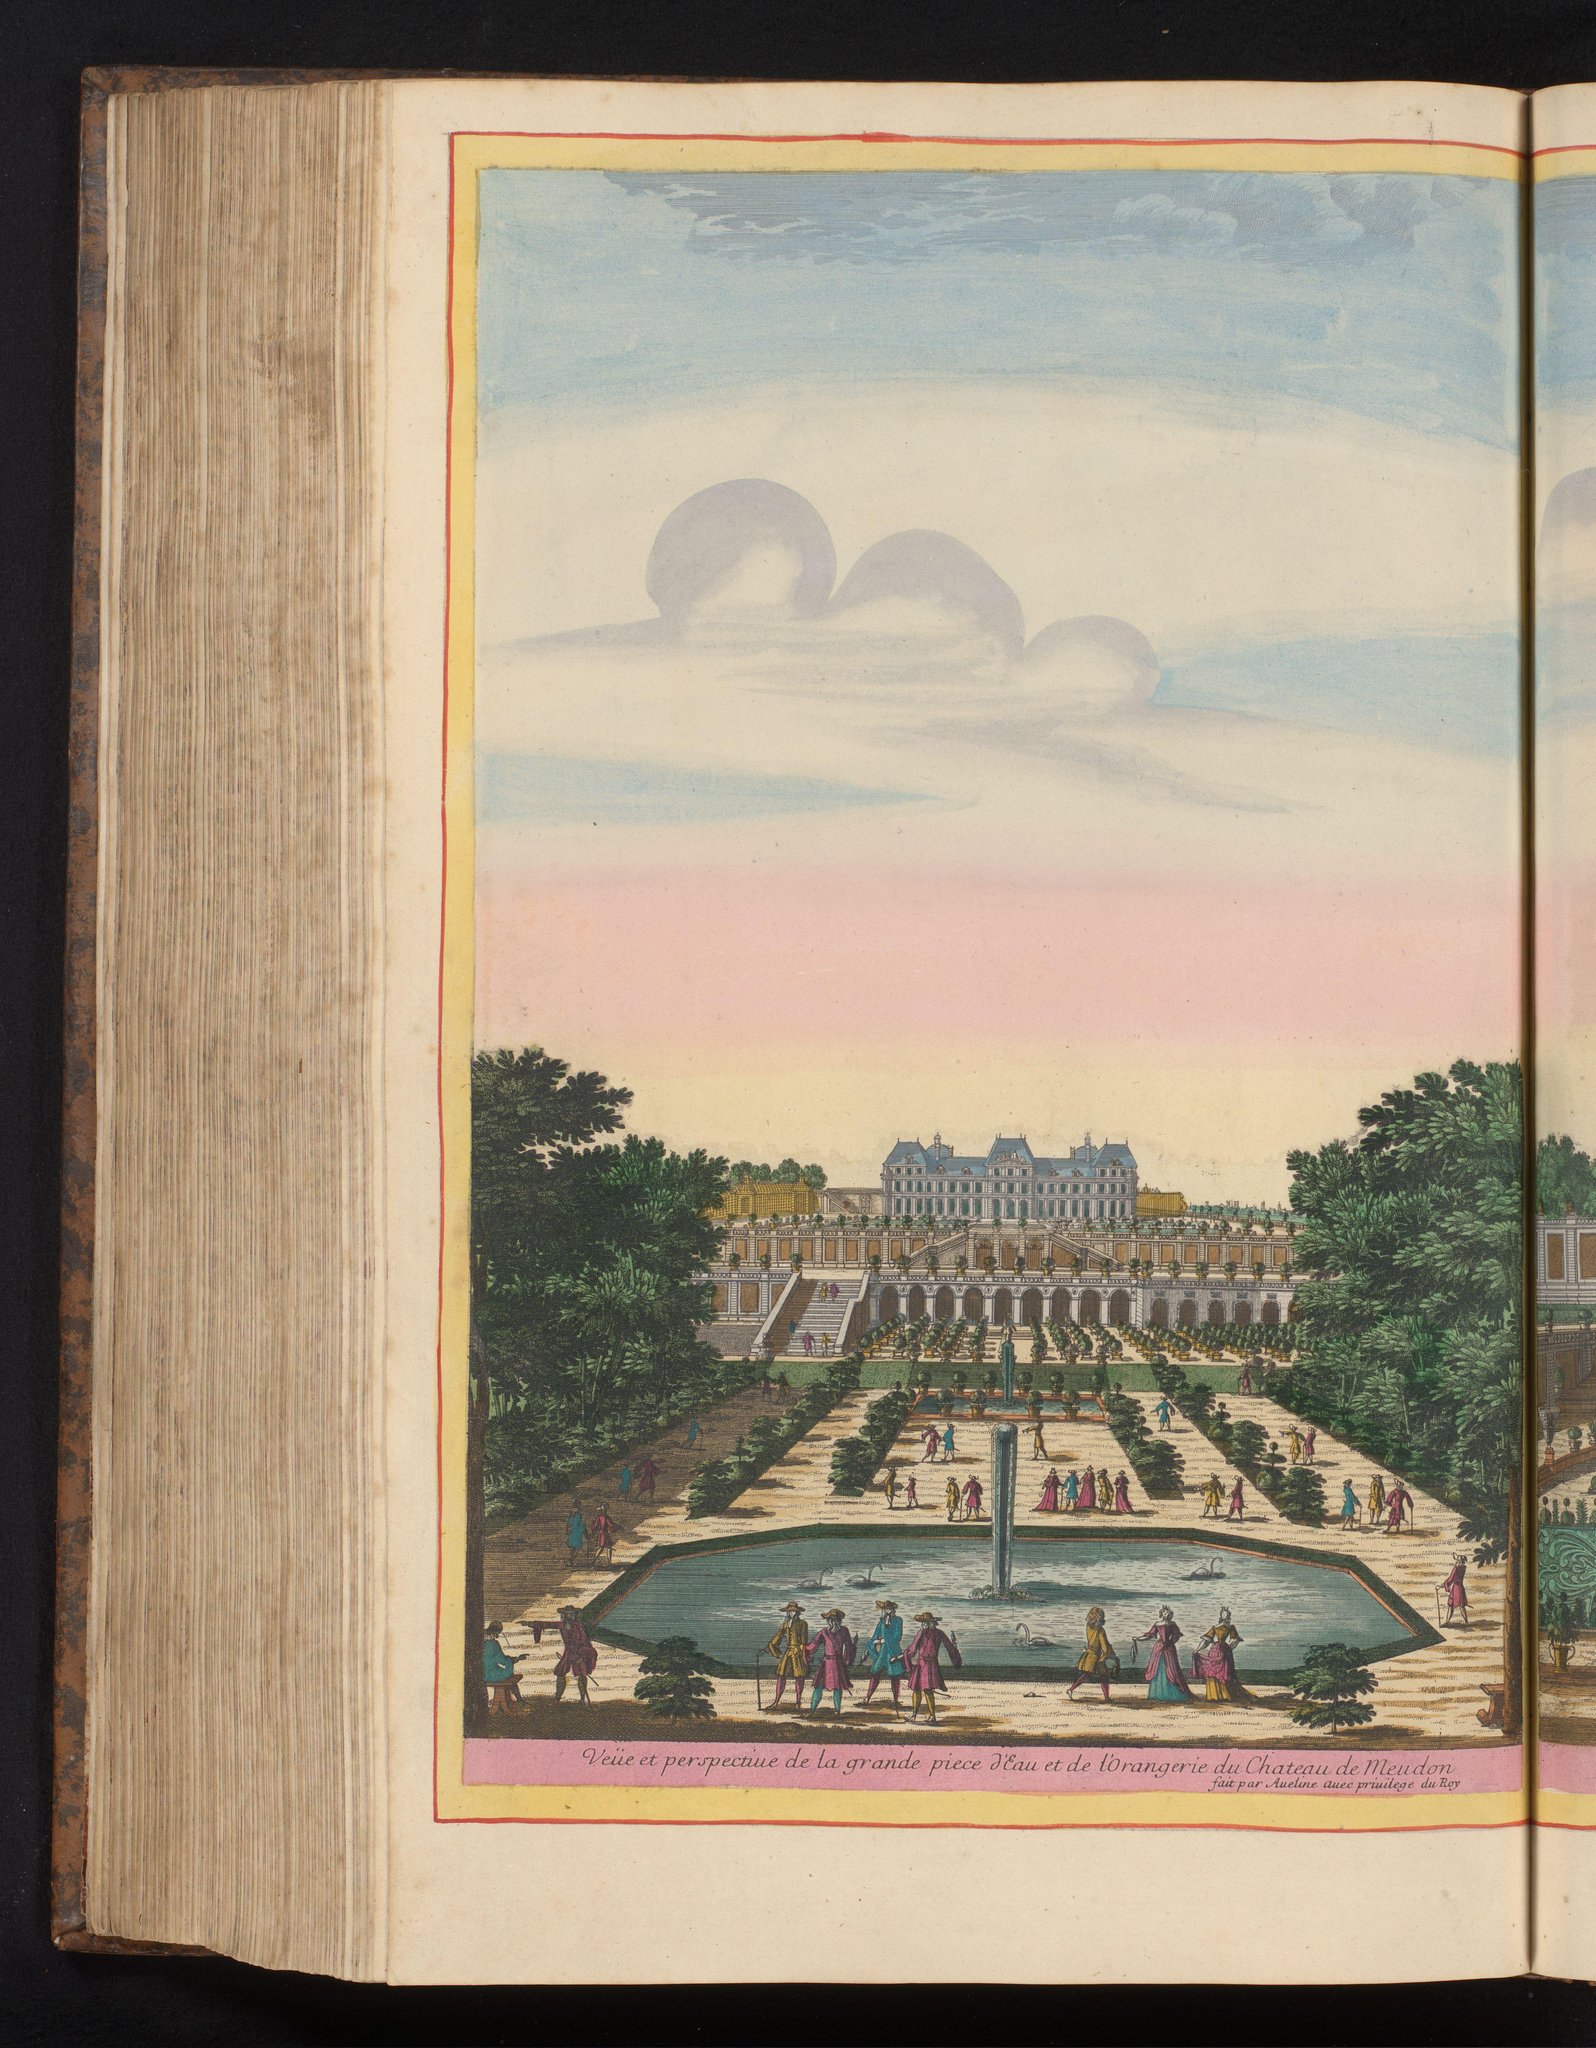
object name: album leaf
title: Veüe et perspective de la grande piece d'Eau et de l'Orangerie du Chateau de Meudon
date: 1675-1717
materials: paper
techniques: etching, hand coloring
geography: paris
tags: castle, french or architectonic garden; formal garden, greenhouse, orangery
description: De prent is langs de bovenrand van de voorstelling afgescheurd. Het bovenste gedeelte is hoger opgeplakt, zodat de lucht hoger is geworden en het formaat van de voorstelling past bij de andere groot formaatvoorstellingen in het album. De voorstelling is aan de bovenzijde aangevuld met een geschilderde lucht.